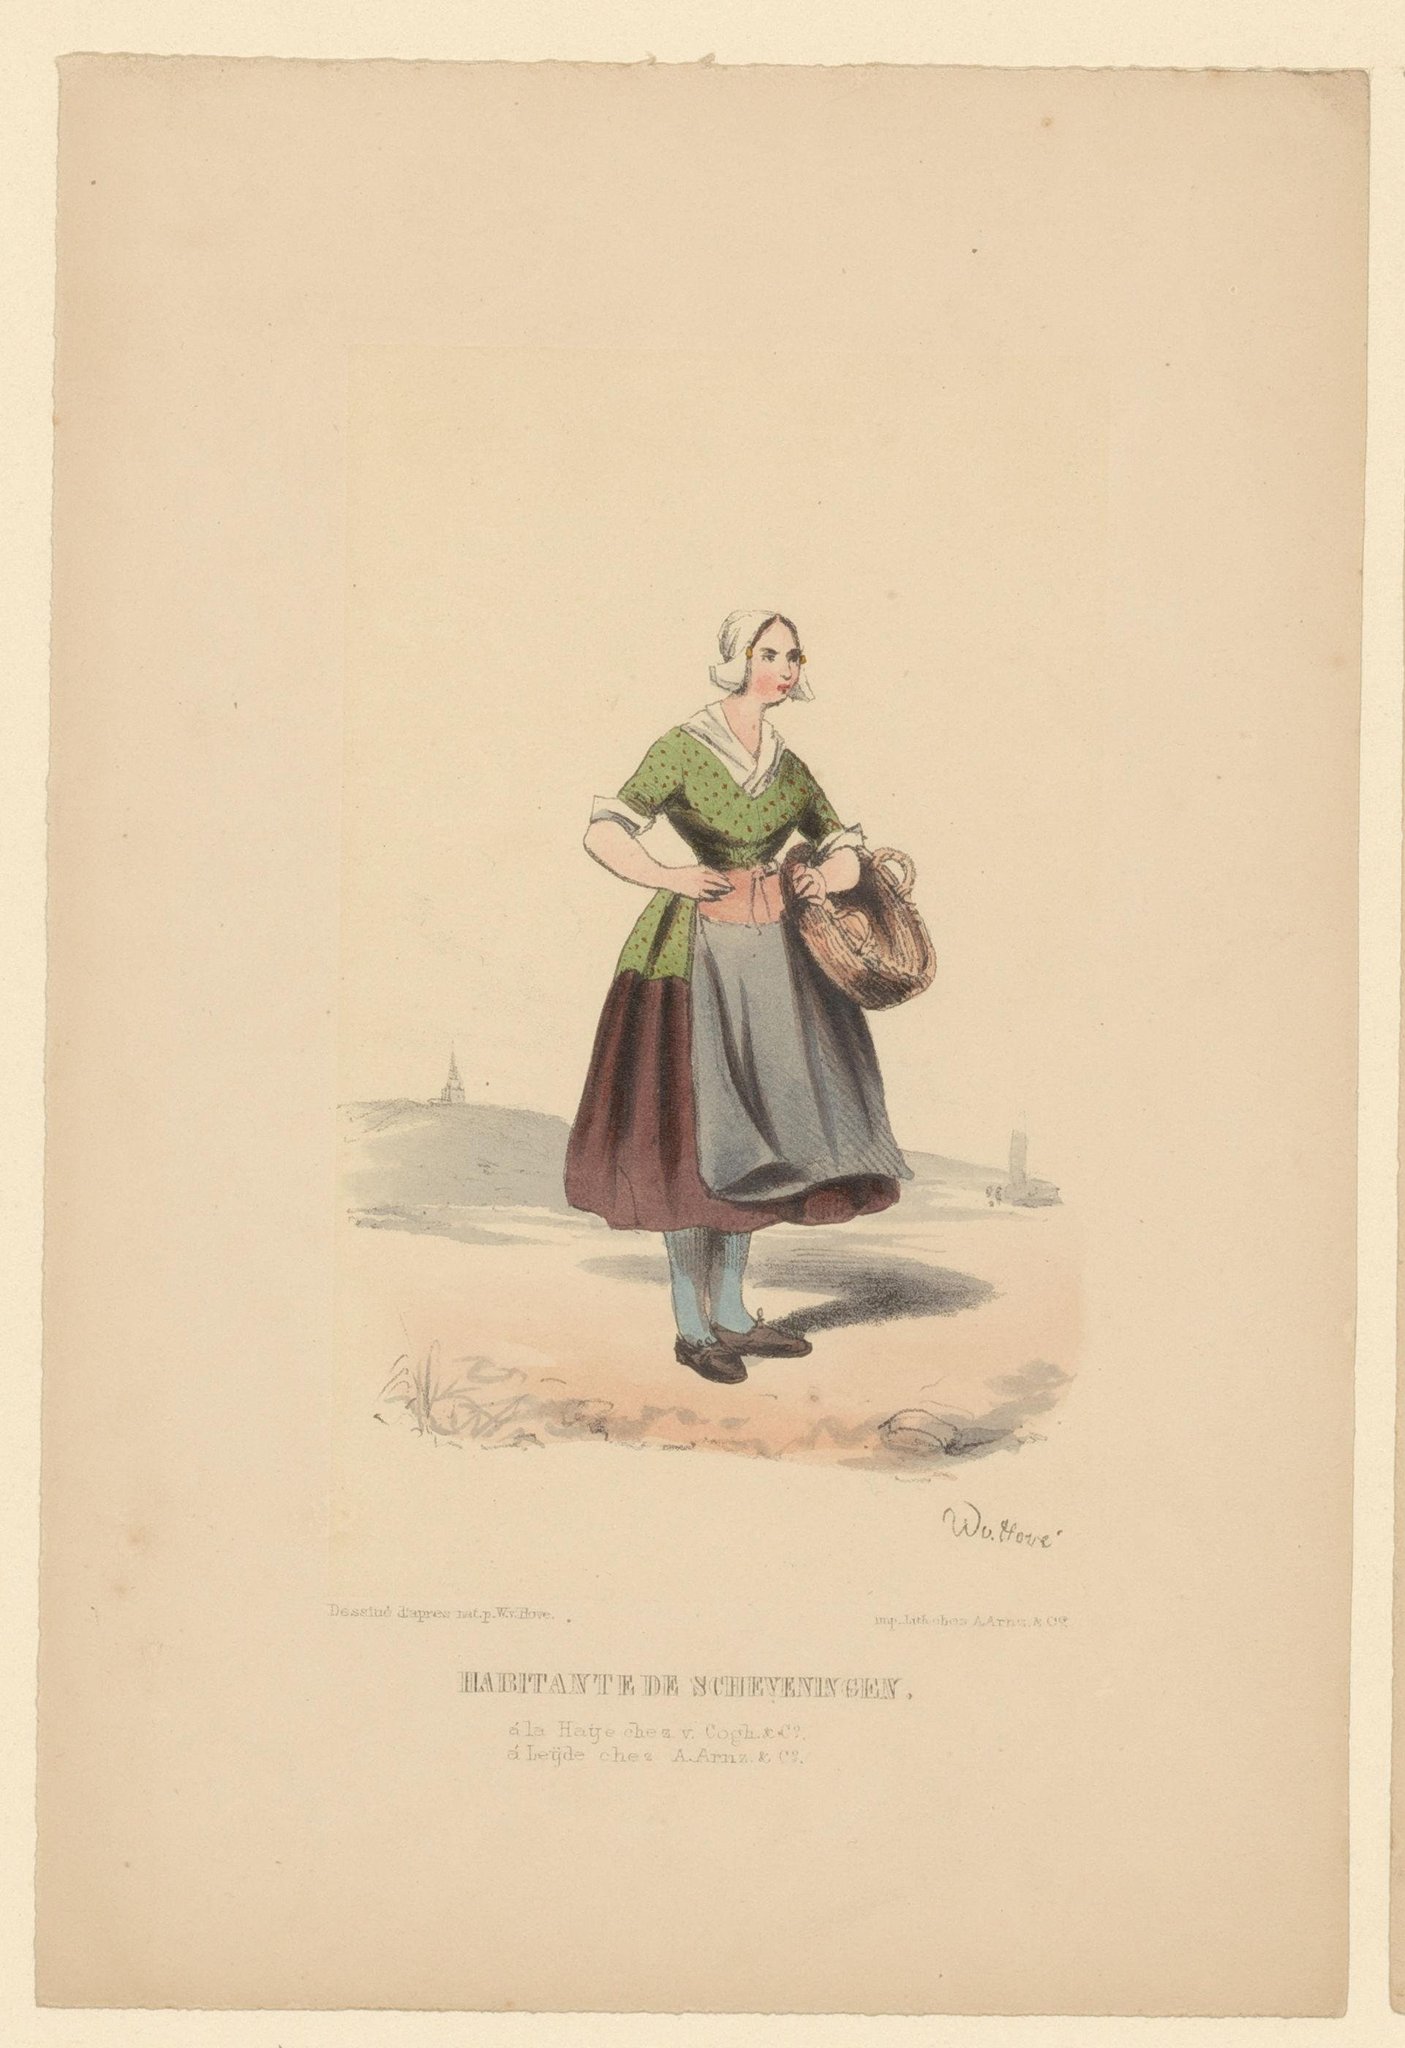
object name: print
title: Habitante de Scheveningen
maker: w. van hove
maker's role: draughtsman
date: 1840-1853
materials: paper, watercolor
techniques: hand coloring, lithograph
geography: netherlands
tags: sea and coastal fishery (+ women (labourers)), clothes, costume (+ women's clothes), folk costume, regional costume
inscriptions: collector's mark, collector's mark: Lugt 1641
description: Vissersvrouw van Scheveningen. Onderwerpsrubrieken binnen de Atlas Zeden en Gewoonten: De Kleeding, Volkskleederdracht, Zuid-Holland.